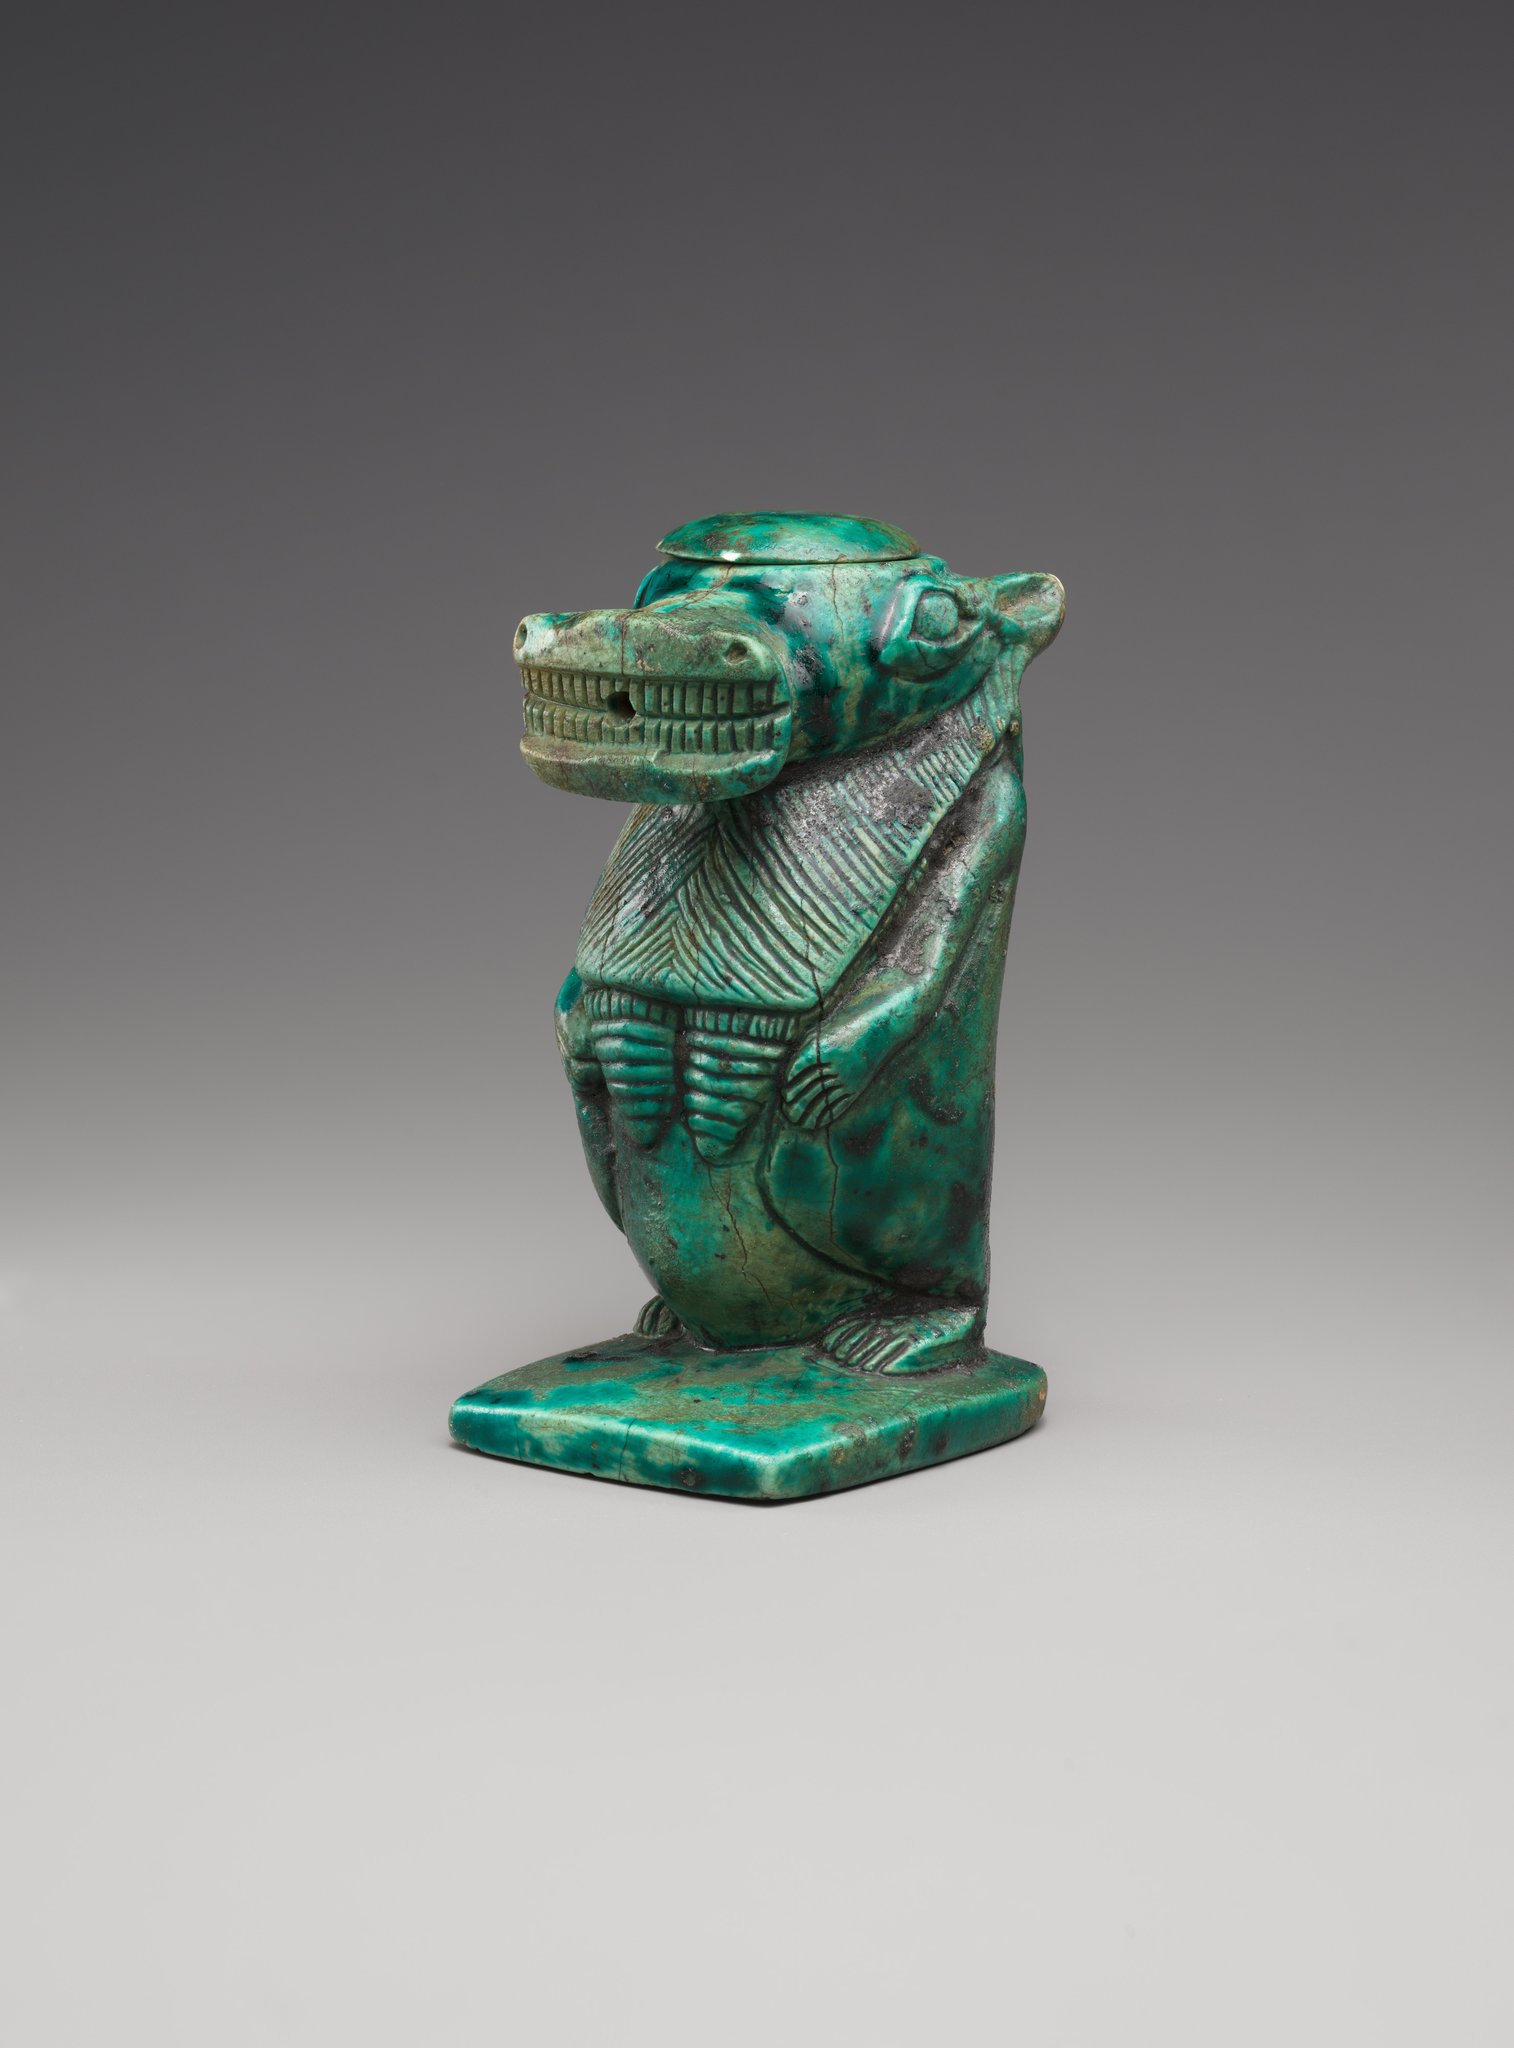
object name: jar, magical, taweret, ipy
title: Magical container in the shape of a hippo goddess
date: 1700-1500 BCE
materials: stone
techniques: glazing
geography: egypt